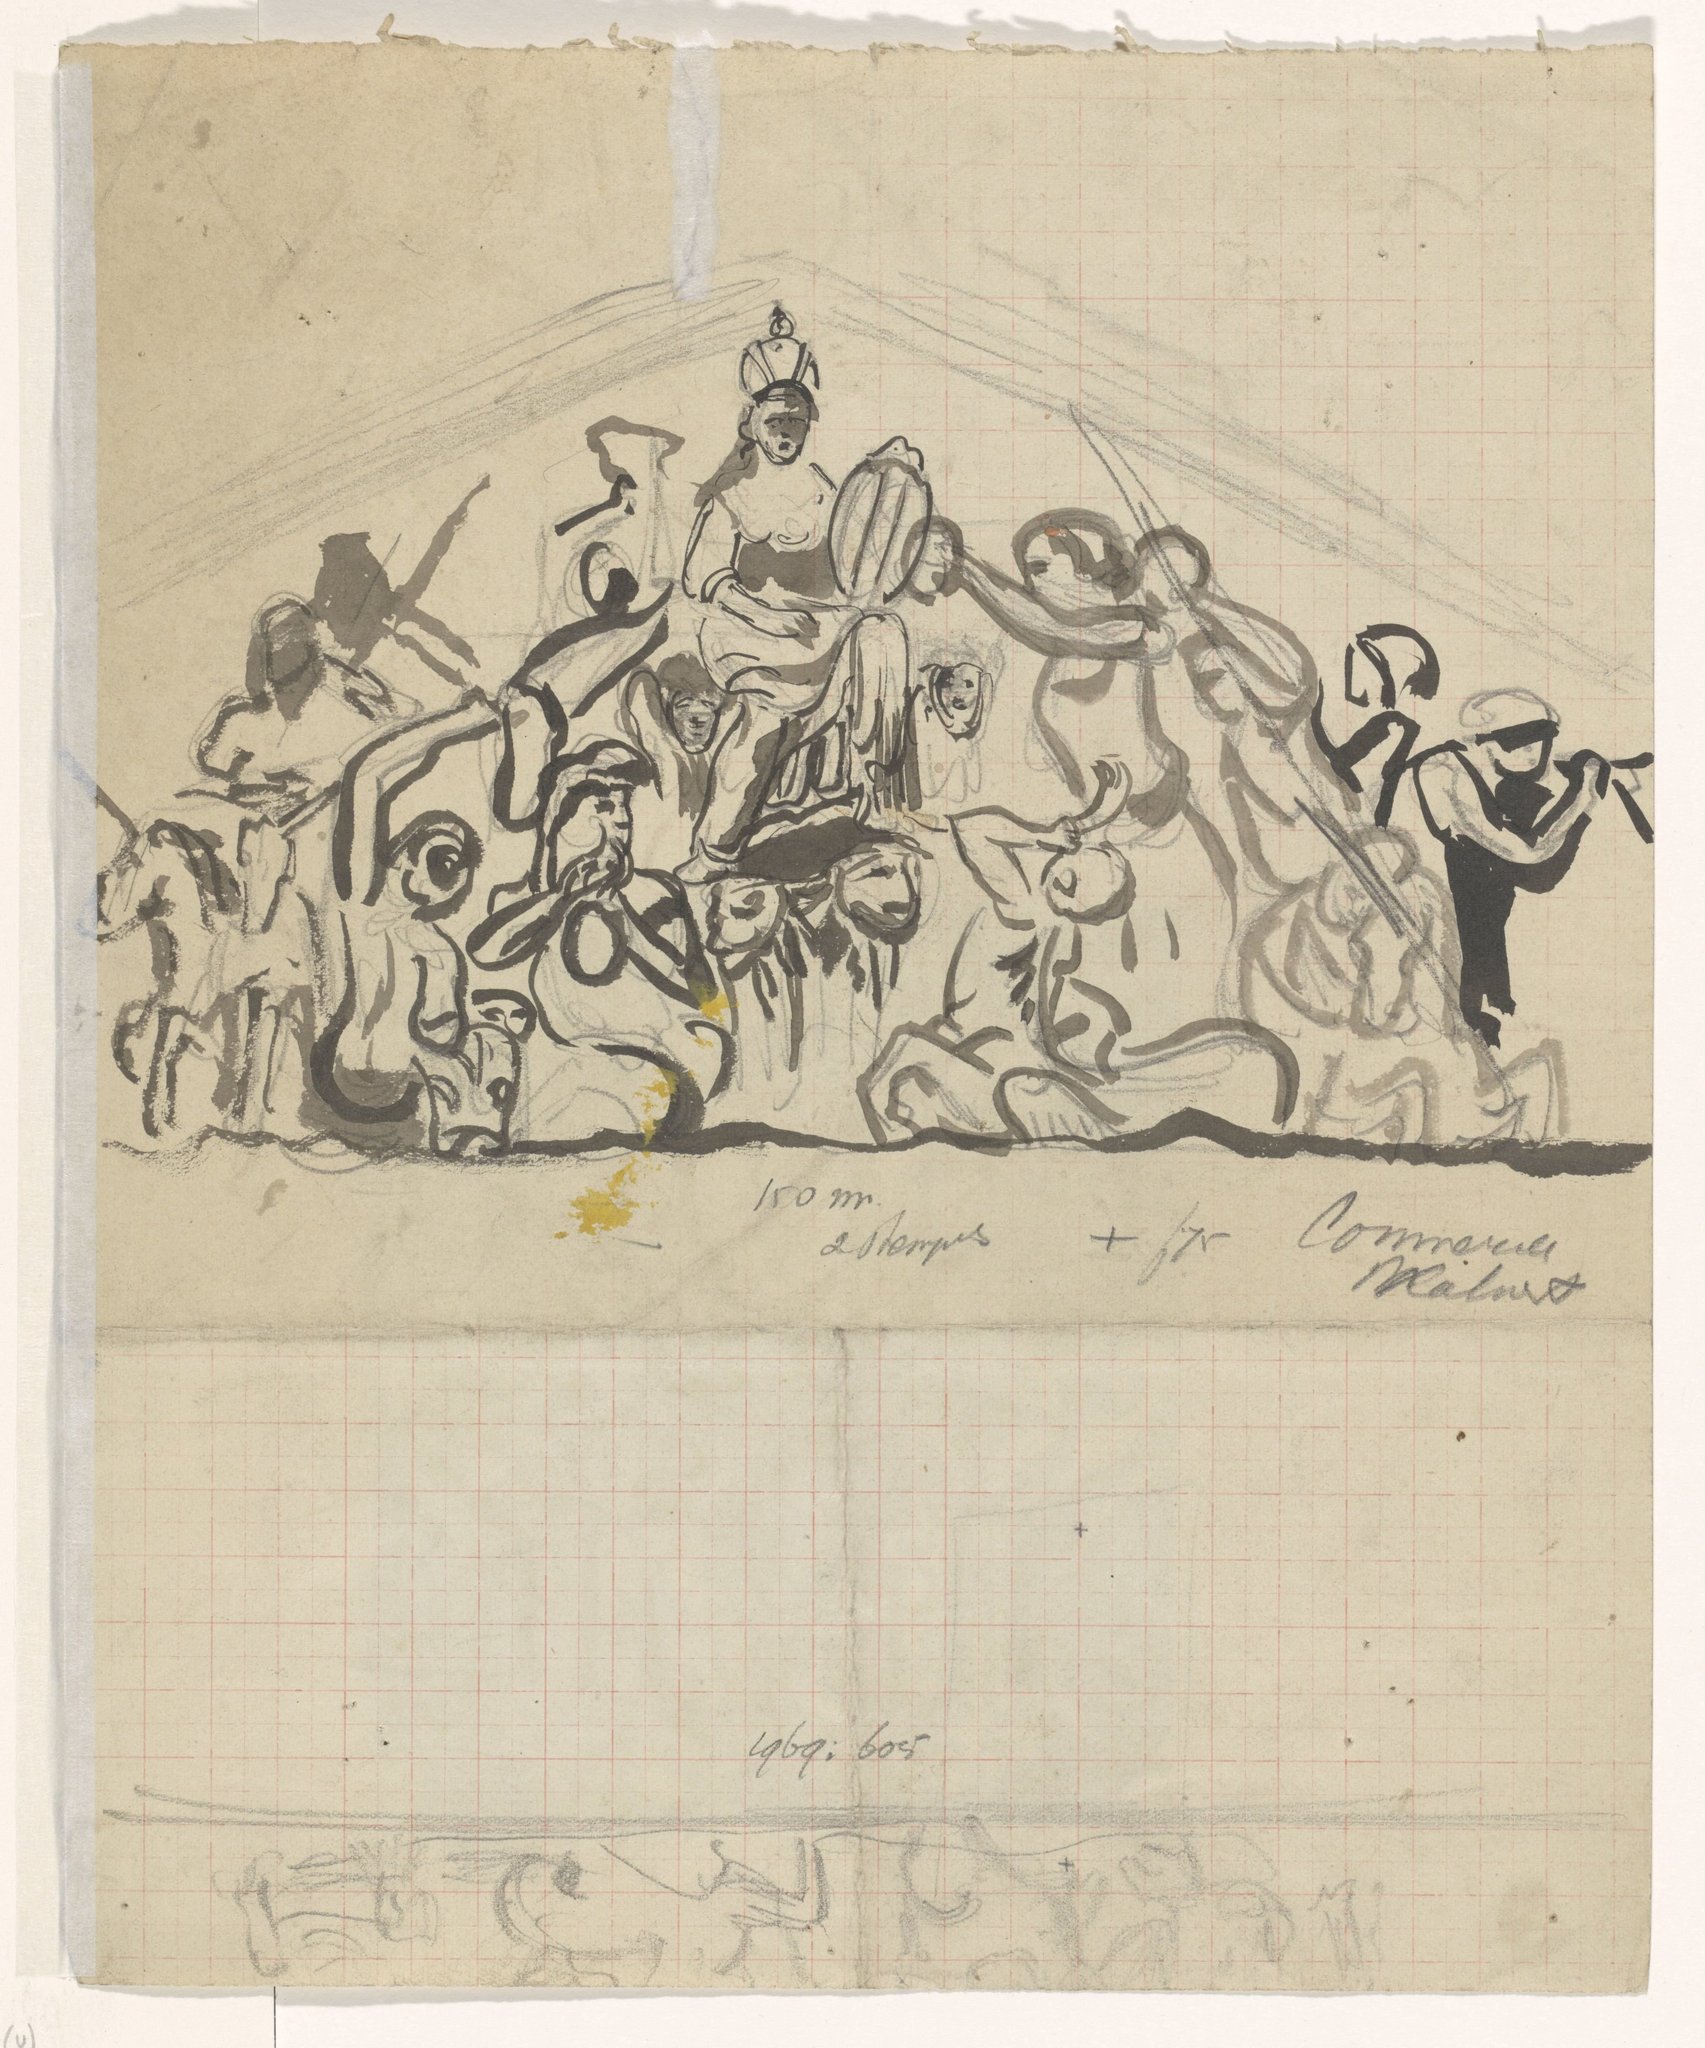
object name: drawing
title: Schets van het front timpaan van het Koninklijk Paleis te Amsterdam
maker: carel adolph lion cachet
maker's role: draughtsman, print maker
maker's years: 1864-1945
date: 1874-1945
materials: paper, pencil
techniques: brush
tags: ornaments ~ art, piece of sculpture, reproduction of a piece of sculpture, front façade, royal palace of amsterdam